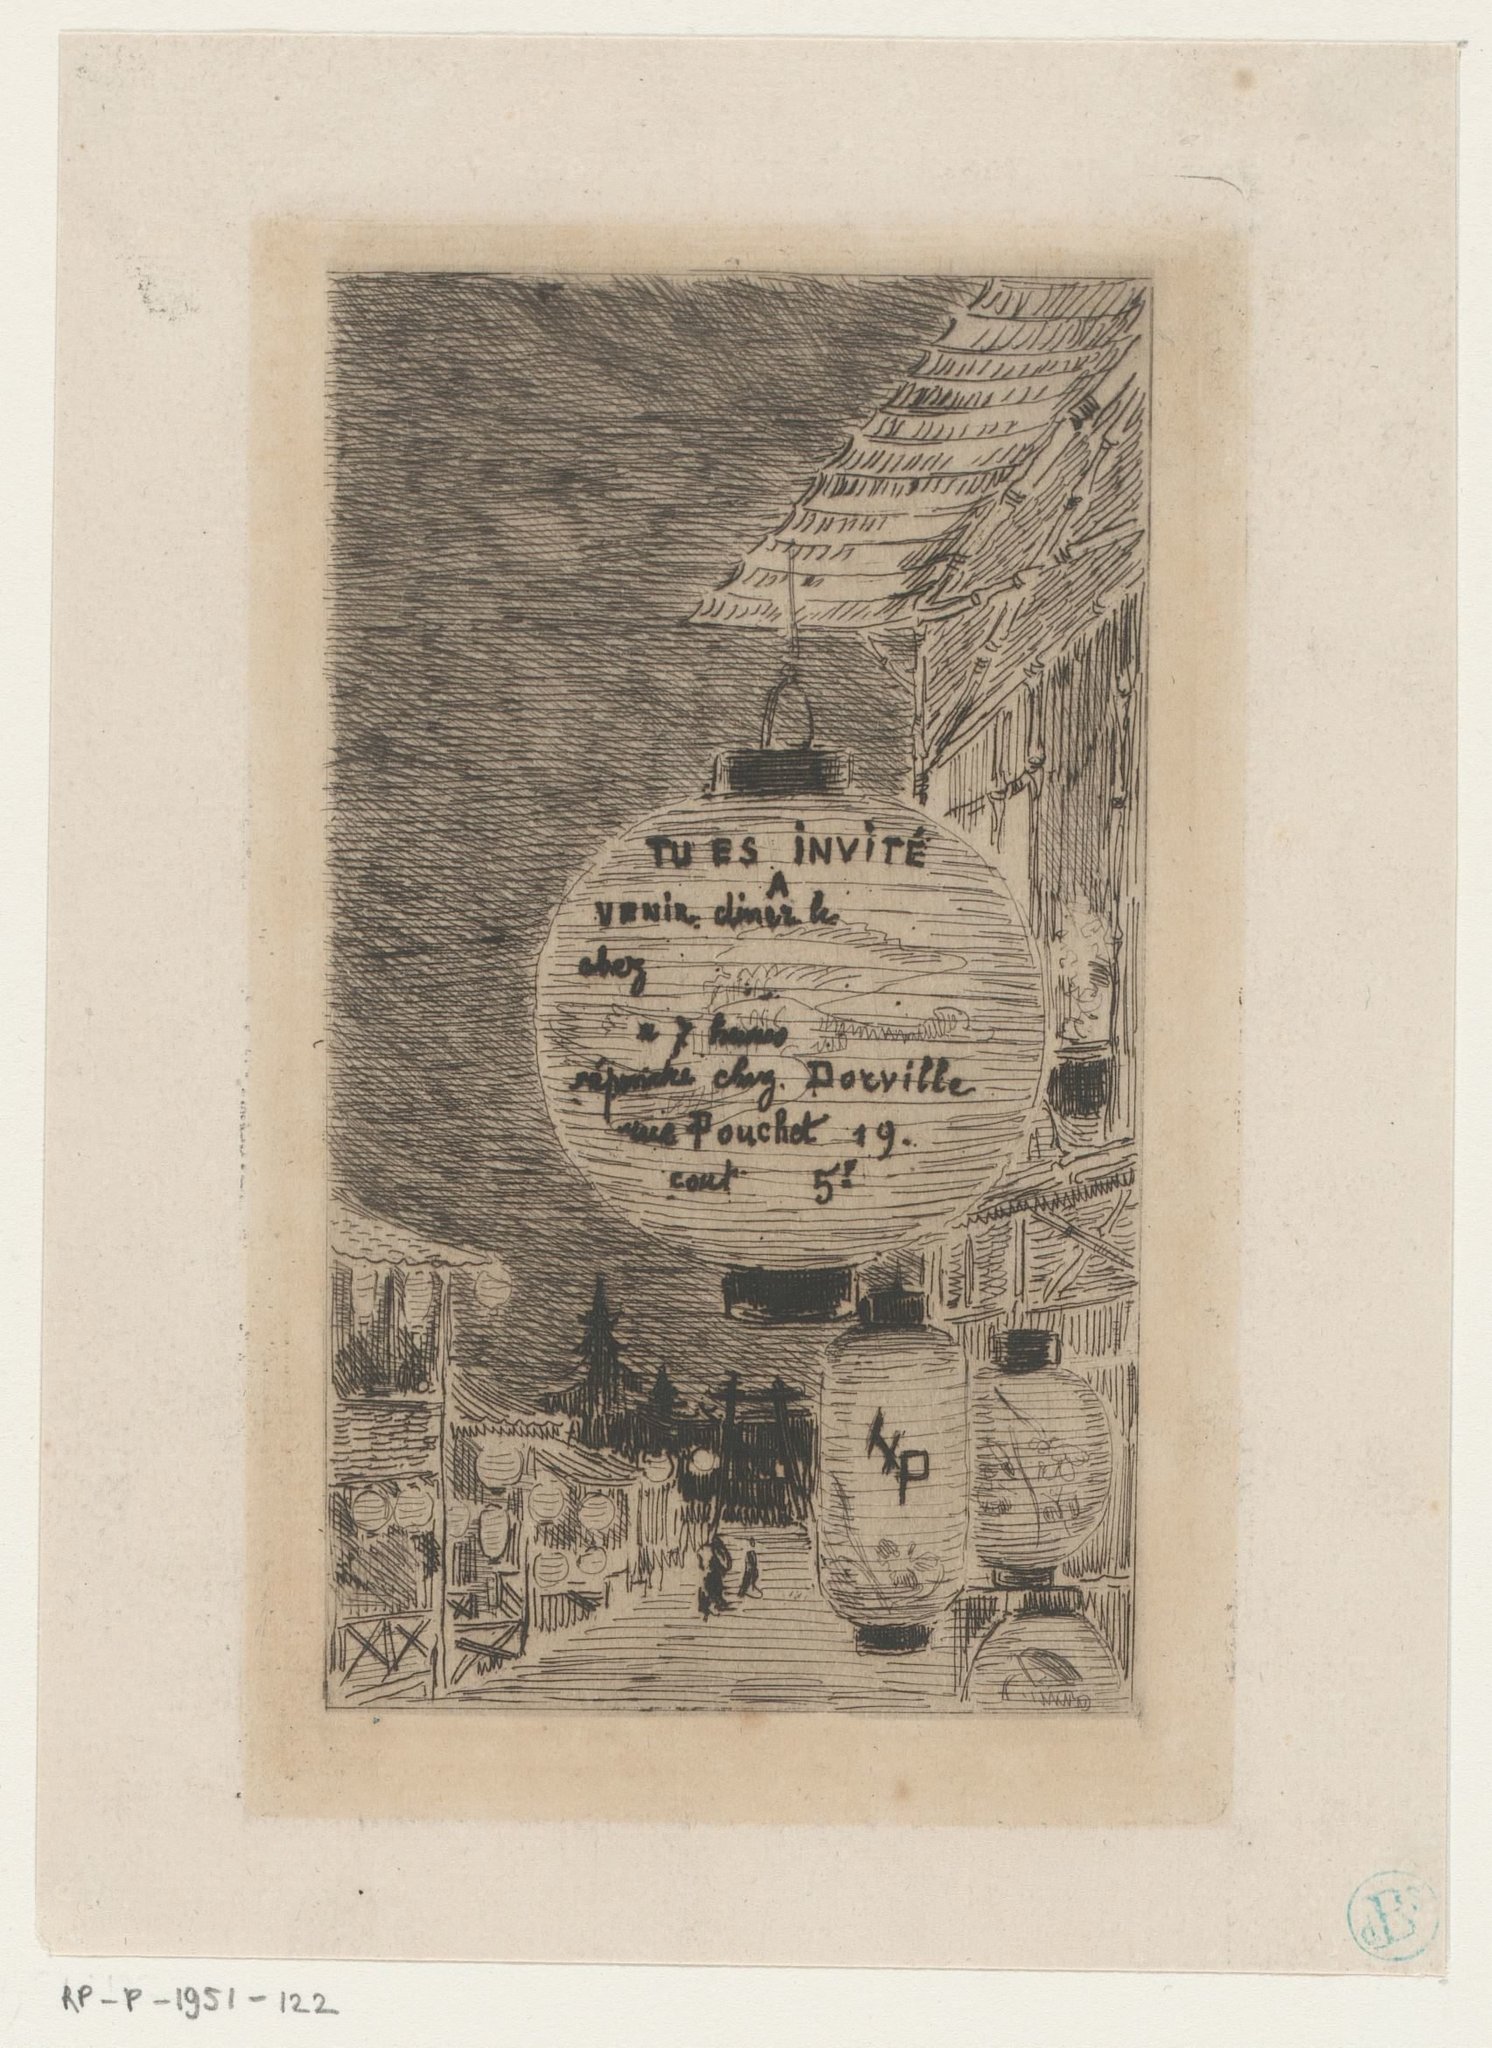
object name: invitation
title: Uitnodiging voor een diner met een gezicht op een straat met lampionnen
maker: henri charles guérard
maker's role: print maker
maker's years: 1846-1897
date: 1856-1897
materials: paper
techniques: etching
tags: lantern, street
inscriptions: collector's mark: Lugt 733, collector's mark: Lugt 2228